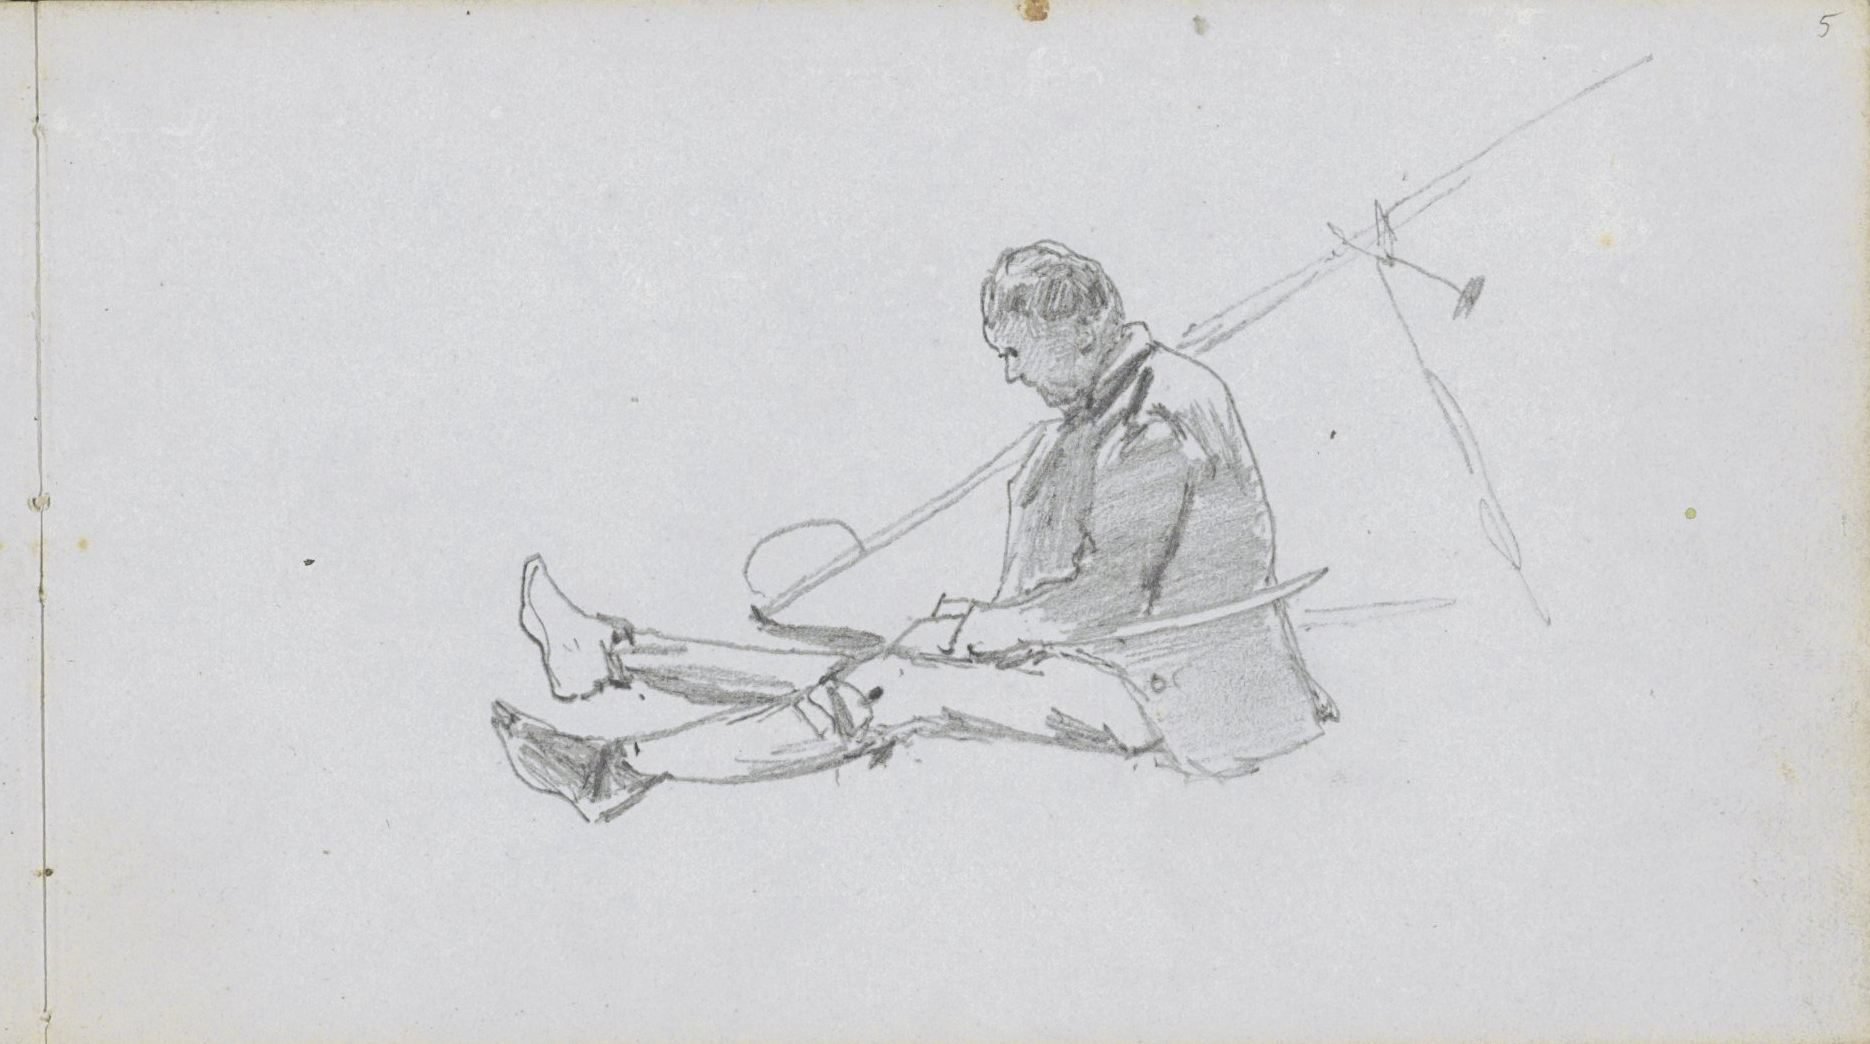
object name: sketchbook leaf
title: Zittende jongen met een boog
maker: johan hendrik weissenbruch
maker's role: draughtsman, painter, print maker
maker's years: 1824-1903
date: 1834-1903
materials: paper, pencil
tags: lower leg, sitting figure (+ young male (human being))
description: Achter de jongen staat een statief, vermoedelijk van hout. Blad 5 recto uit een schetsboek met 39 bladen.